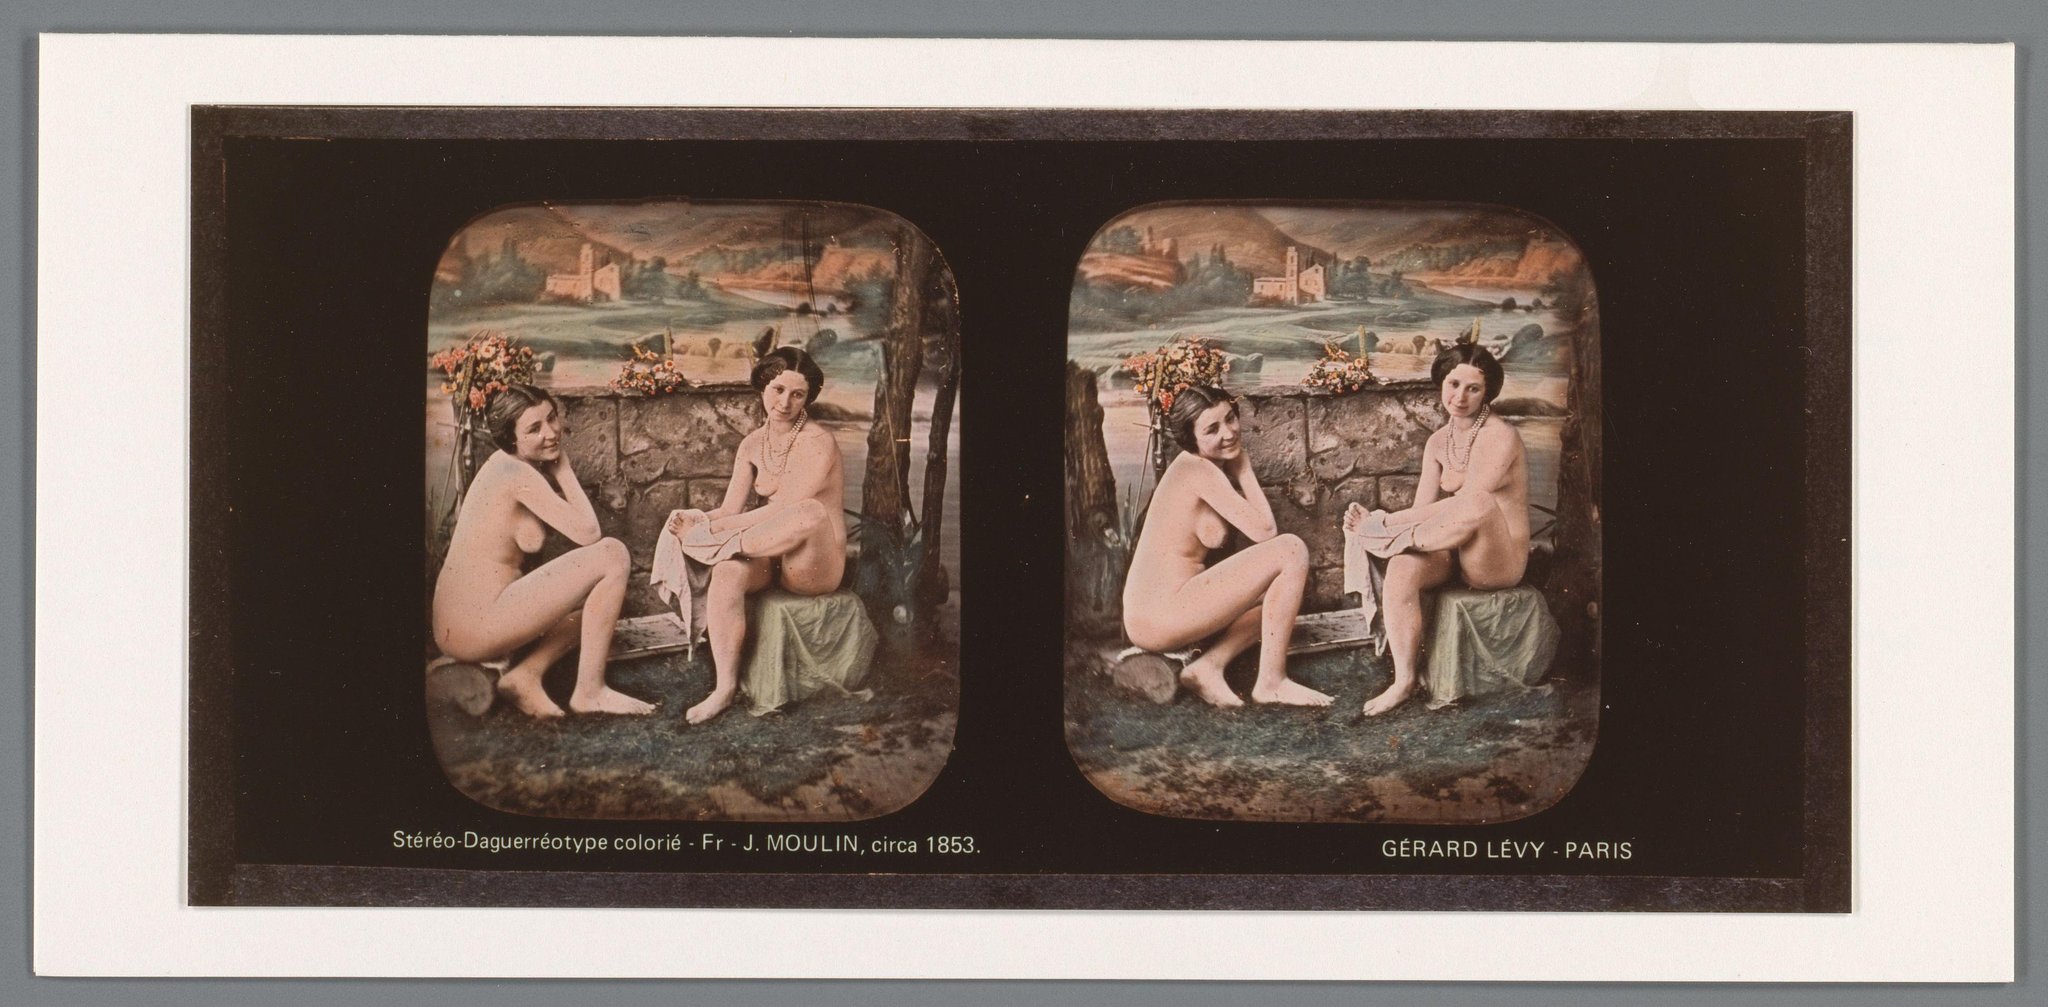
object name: photograph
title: Nieuwjaarswens voor 1978 met een fotoreproductie van een stereo-daguerreotypie van twee naakte vrouwen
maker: Anonymous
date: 1977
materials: paper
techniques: chromogenic print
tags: l.j. hartkamp, woman (showing herself) undressed, quasi-nude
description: Nieuwjaarswens van Gérard Lévy en mogelijk François Lefranc gericht aan Bert Hartkamp.